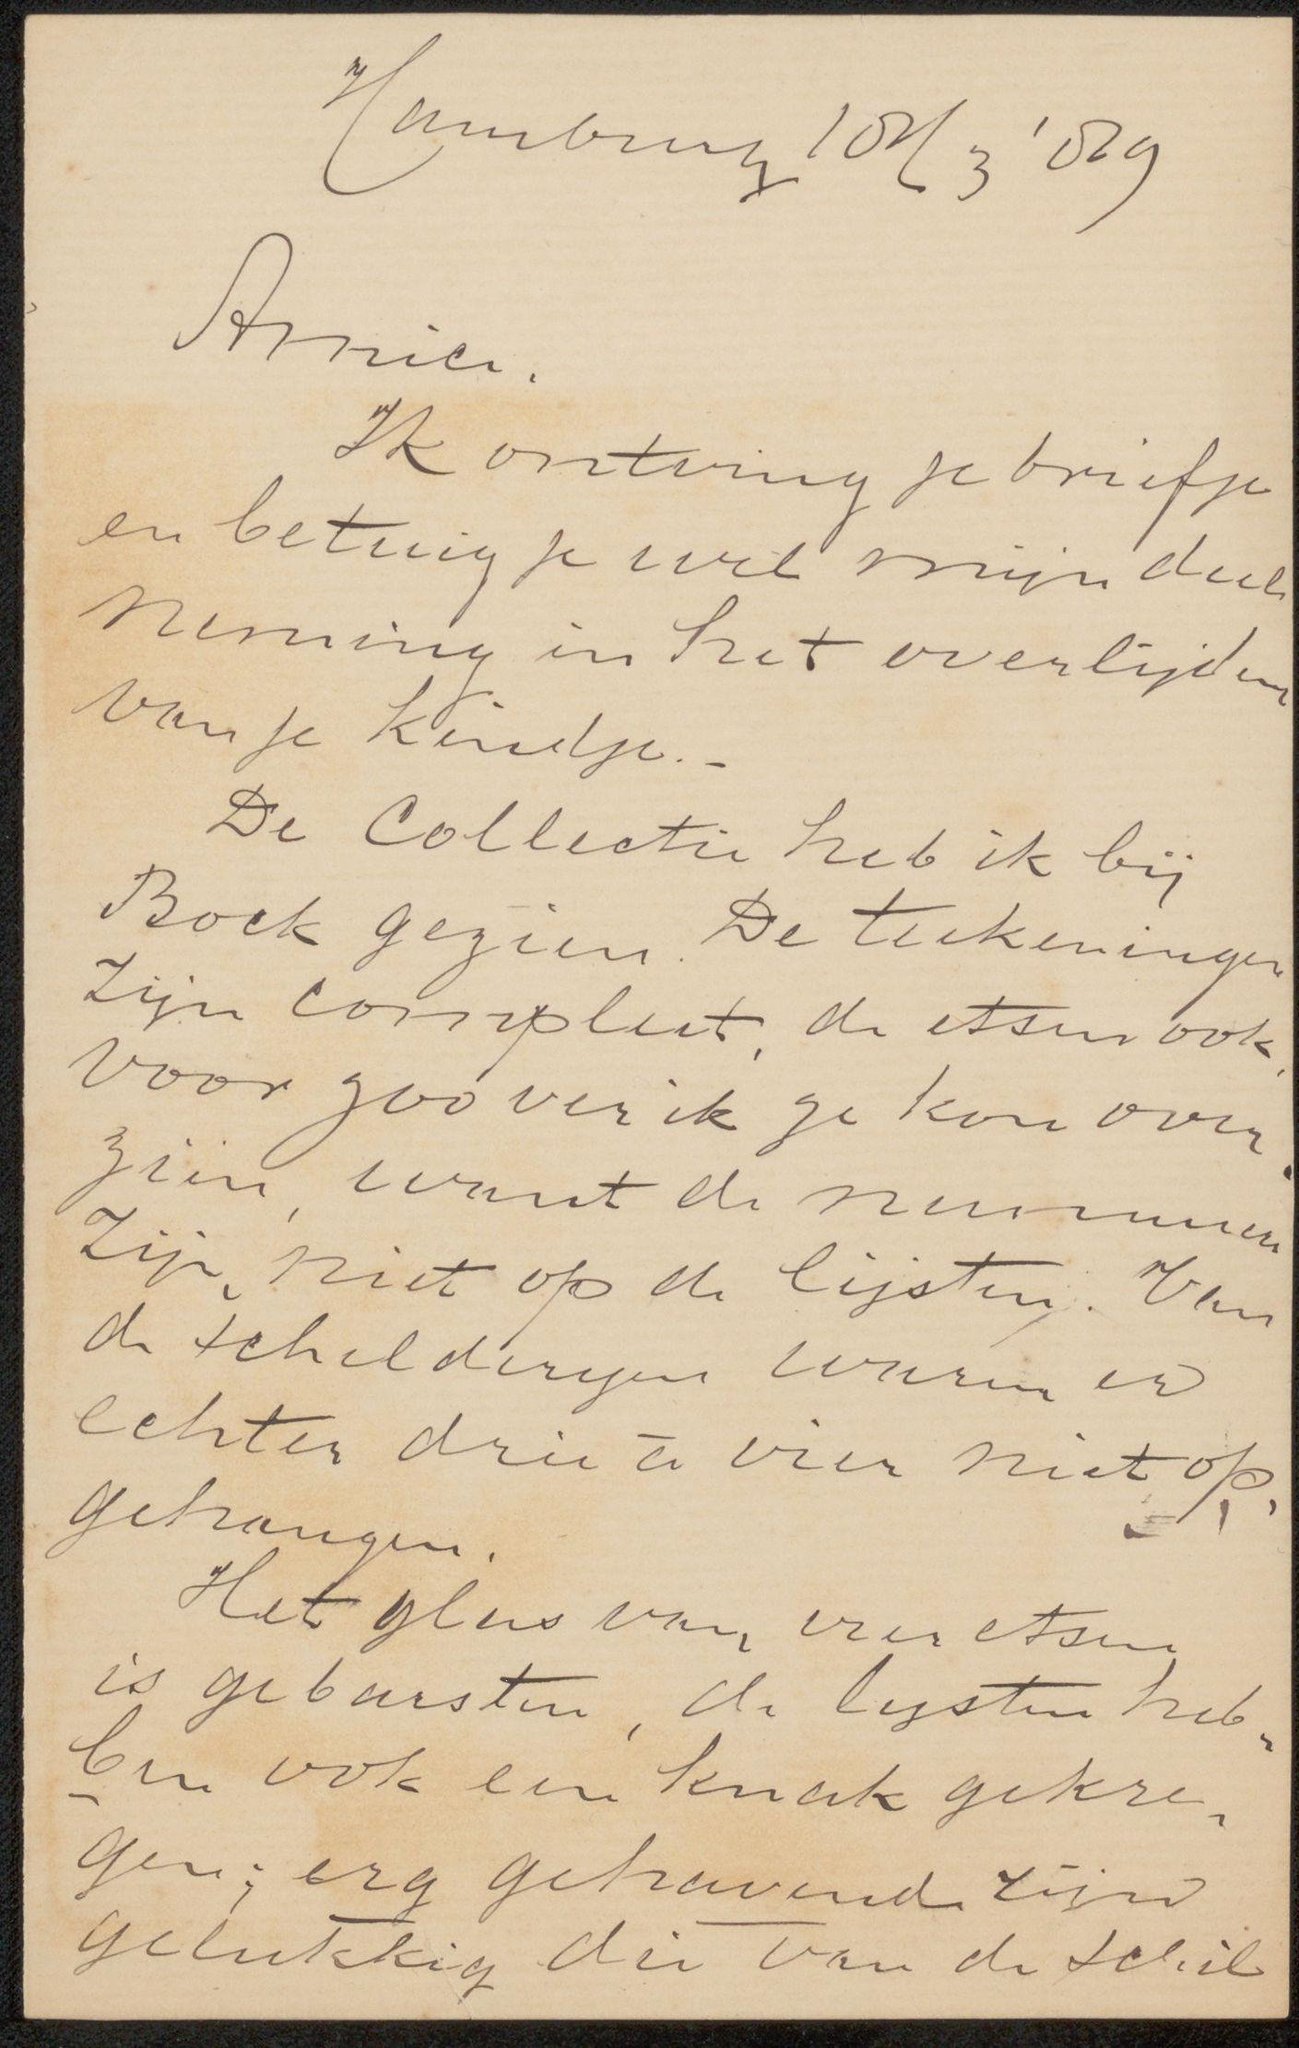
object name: letter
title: Brief aan Philip Zilcken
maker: arij prins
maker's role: industrieel, schrijver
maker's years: 1860-1922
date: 1889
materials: ink, paper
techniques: pen, writing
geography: hamburg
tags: paris, joris-karl huysmans, the hague, draughtsman, philip zilcken, drawing, the graphic arts, family life, painting (including book-illumination, miniature-painting), cologne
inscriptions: collector's mark: ‘RPK’